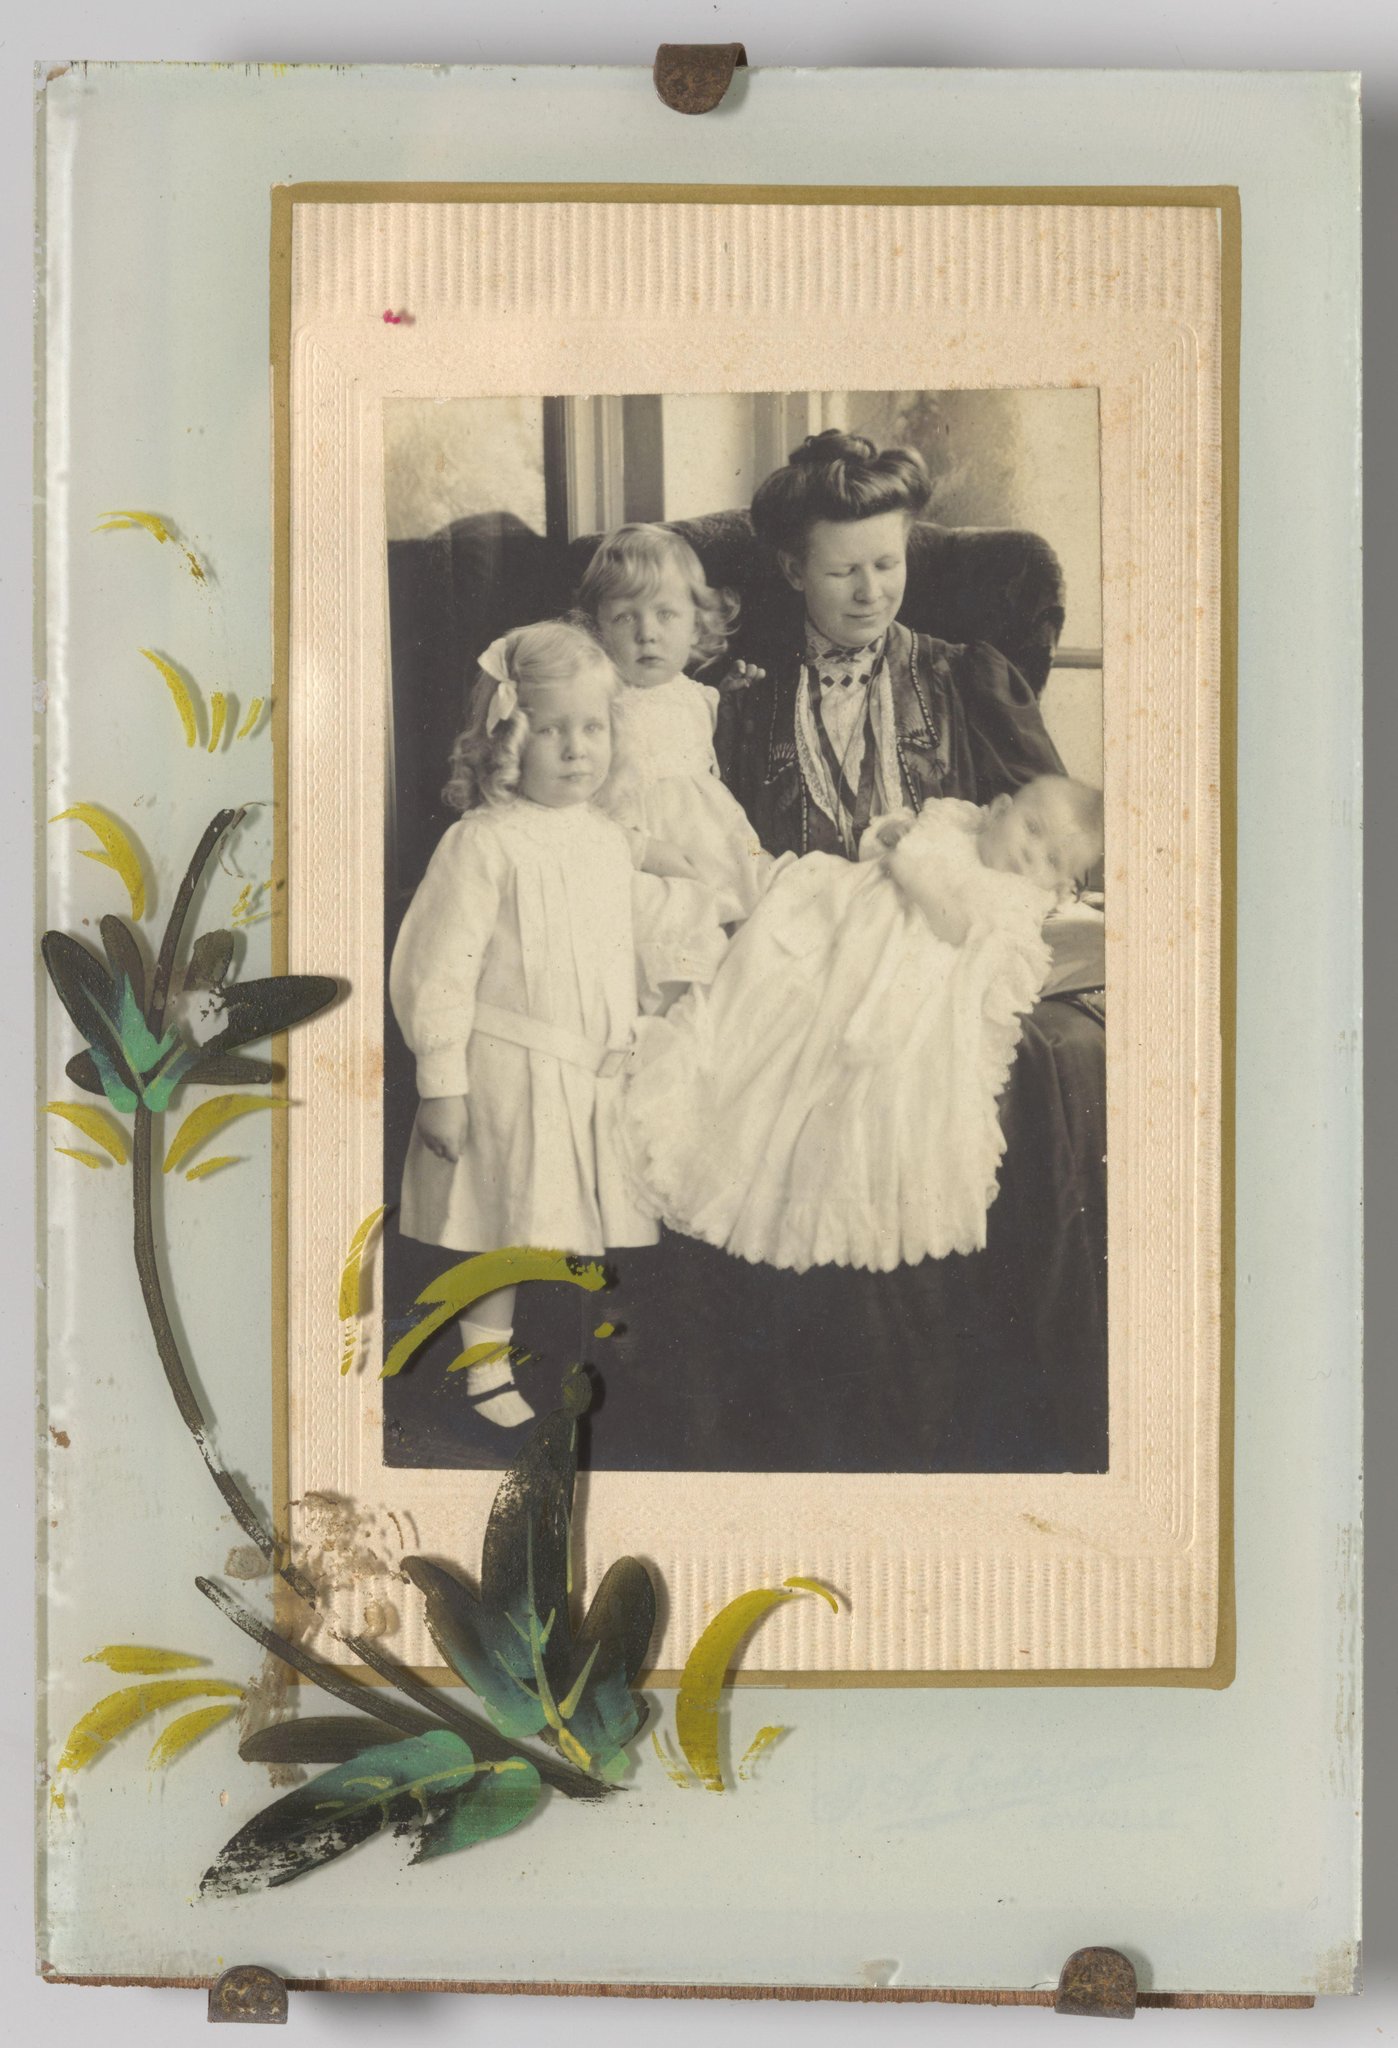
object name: frame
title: Portret van een onbekende vrouw met drie kinderen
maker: Anonymous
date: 1880-1910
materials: paper, cardboard, glass, metal, paint, wood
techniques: brush, gelatin silver print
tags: anonymous historical person portrayed, mother and child(ren), woman and child(ren) (family group)